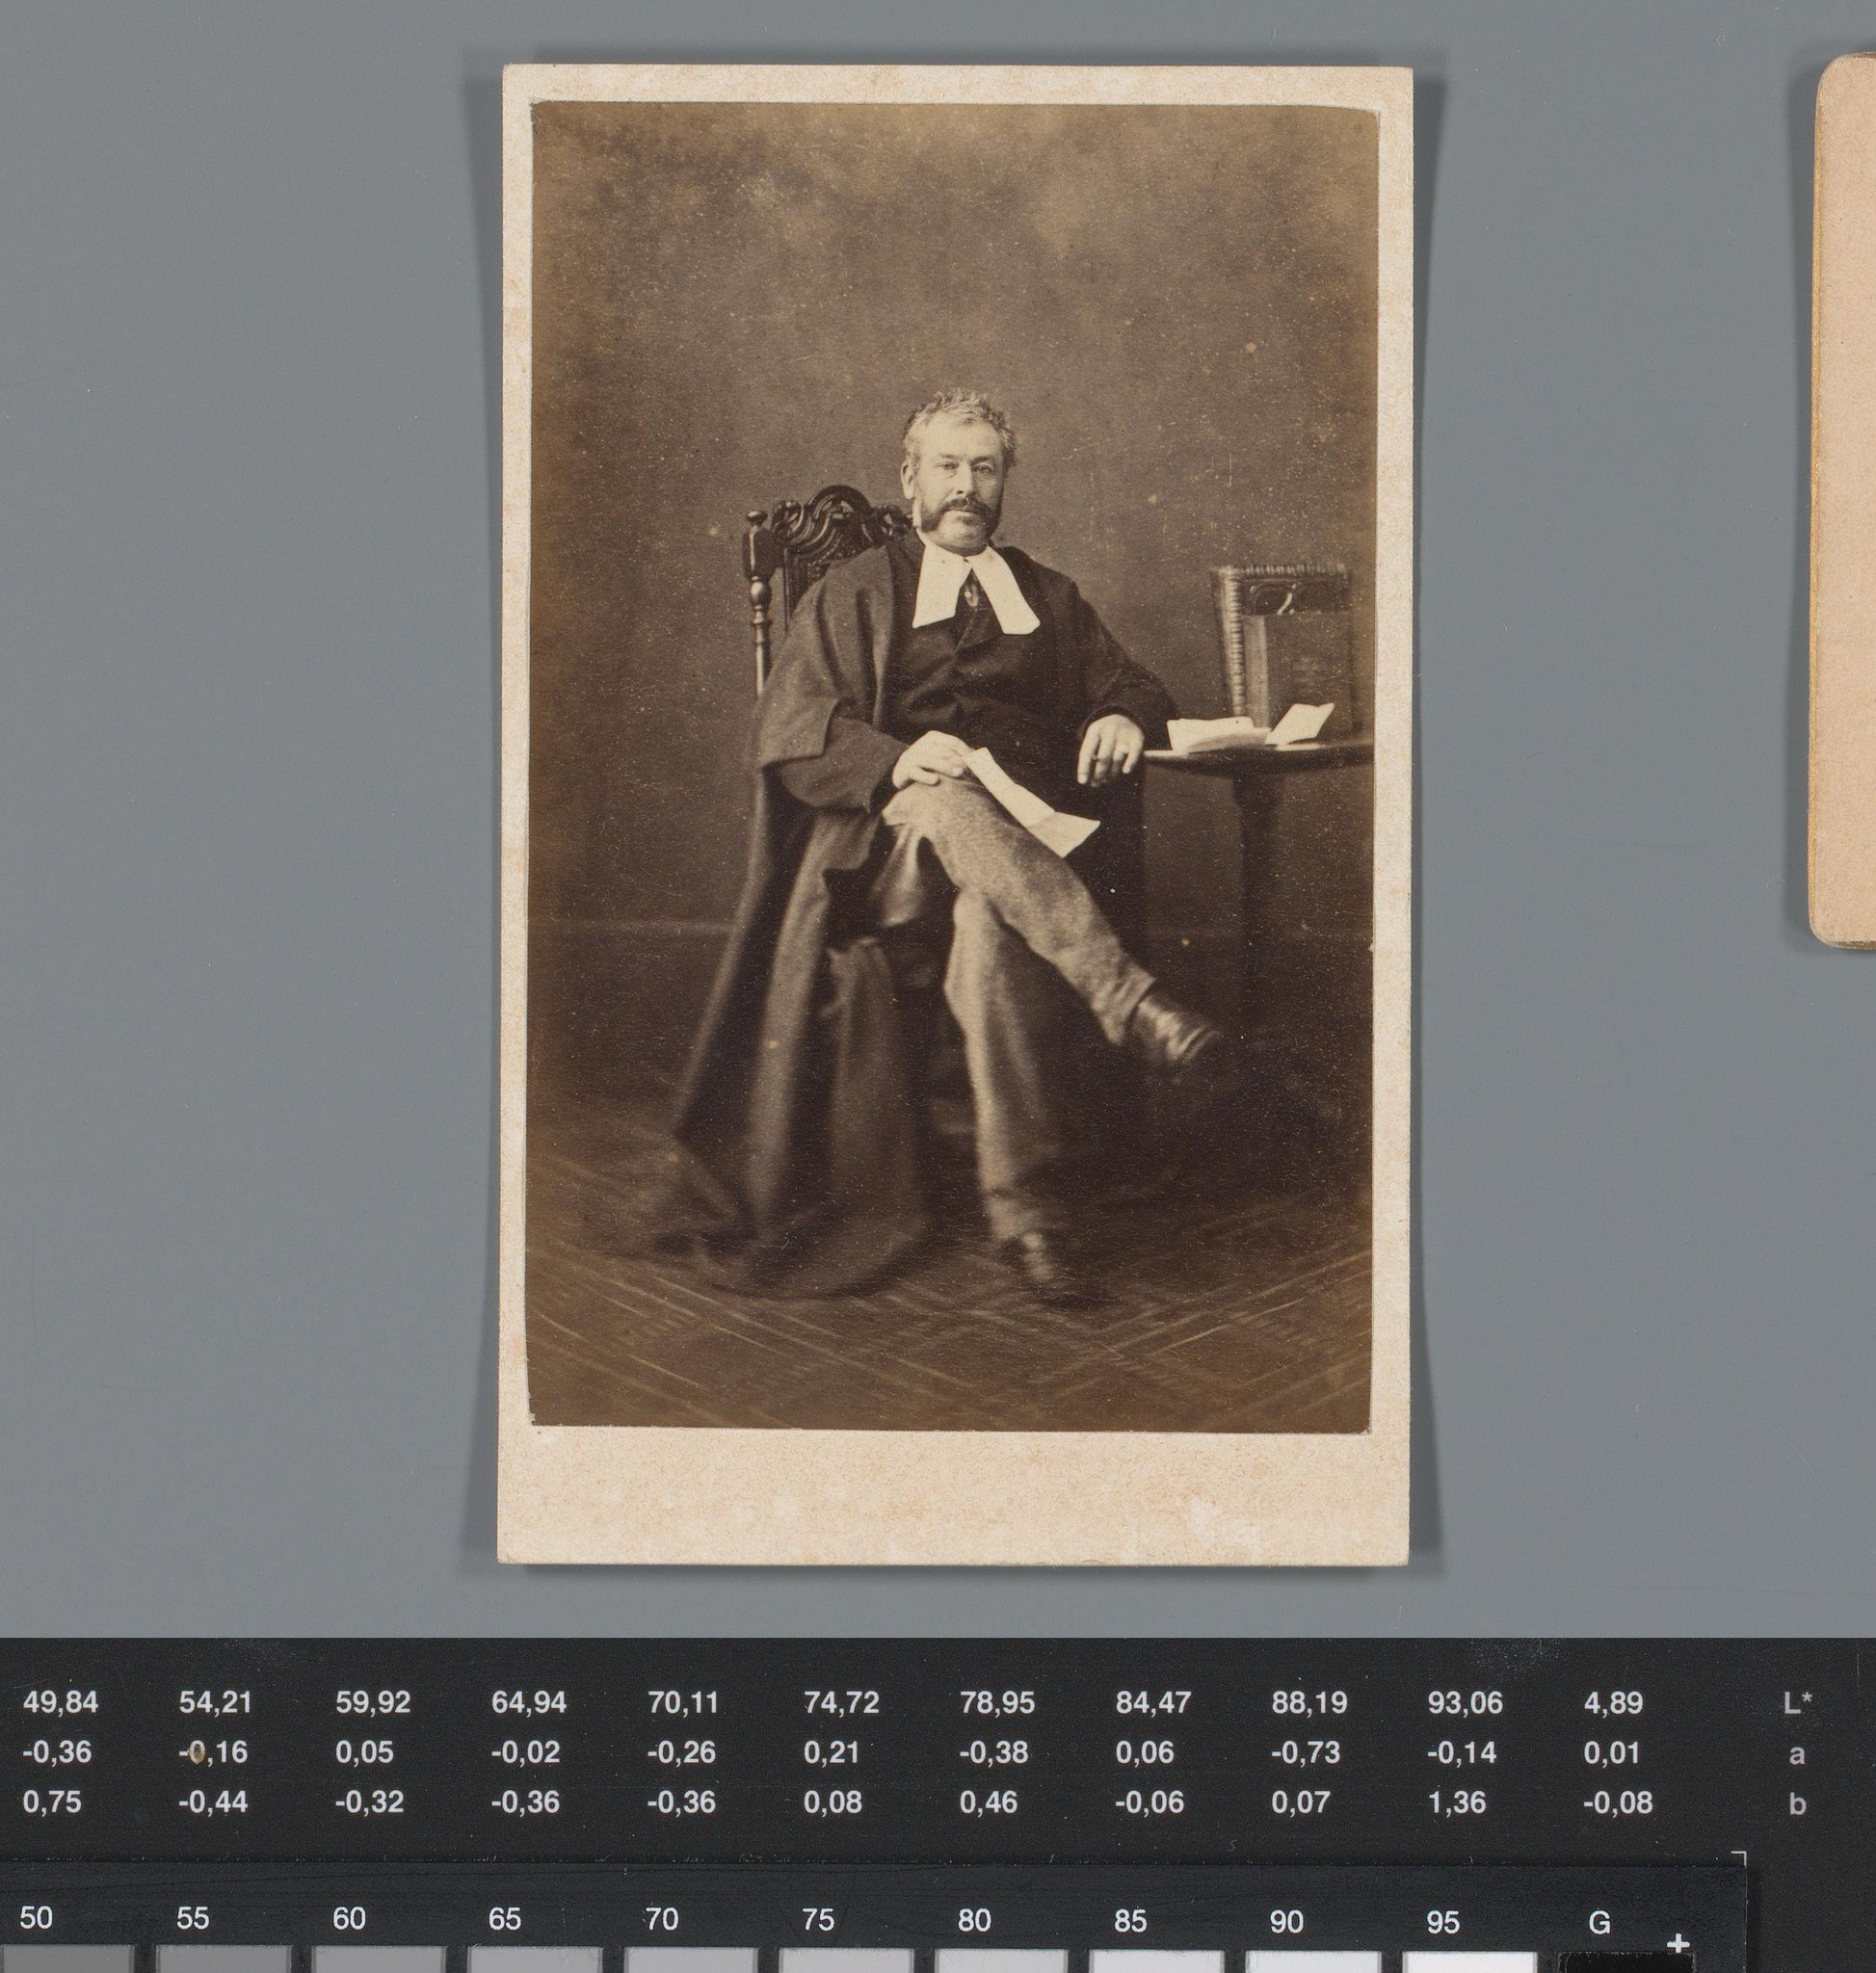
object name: carte de visite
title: Visitekaart van advocaat Mr. W.F. Pratt, werkzaam te Wootton Bassett, met foto van onbekende man (waarschijnlijk W.F. Pratt)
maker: Anonymous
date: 1850-1915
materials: cardboard, photographic support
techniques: albumen print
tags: advertising, lawyer, attorney at law, historical persons not known by name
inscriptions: inscription: ‘MR. W. F. PRATT, SOLICITOR AND ATTORNEY, (...)’